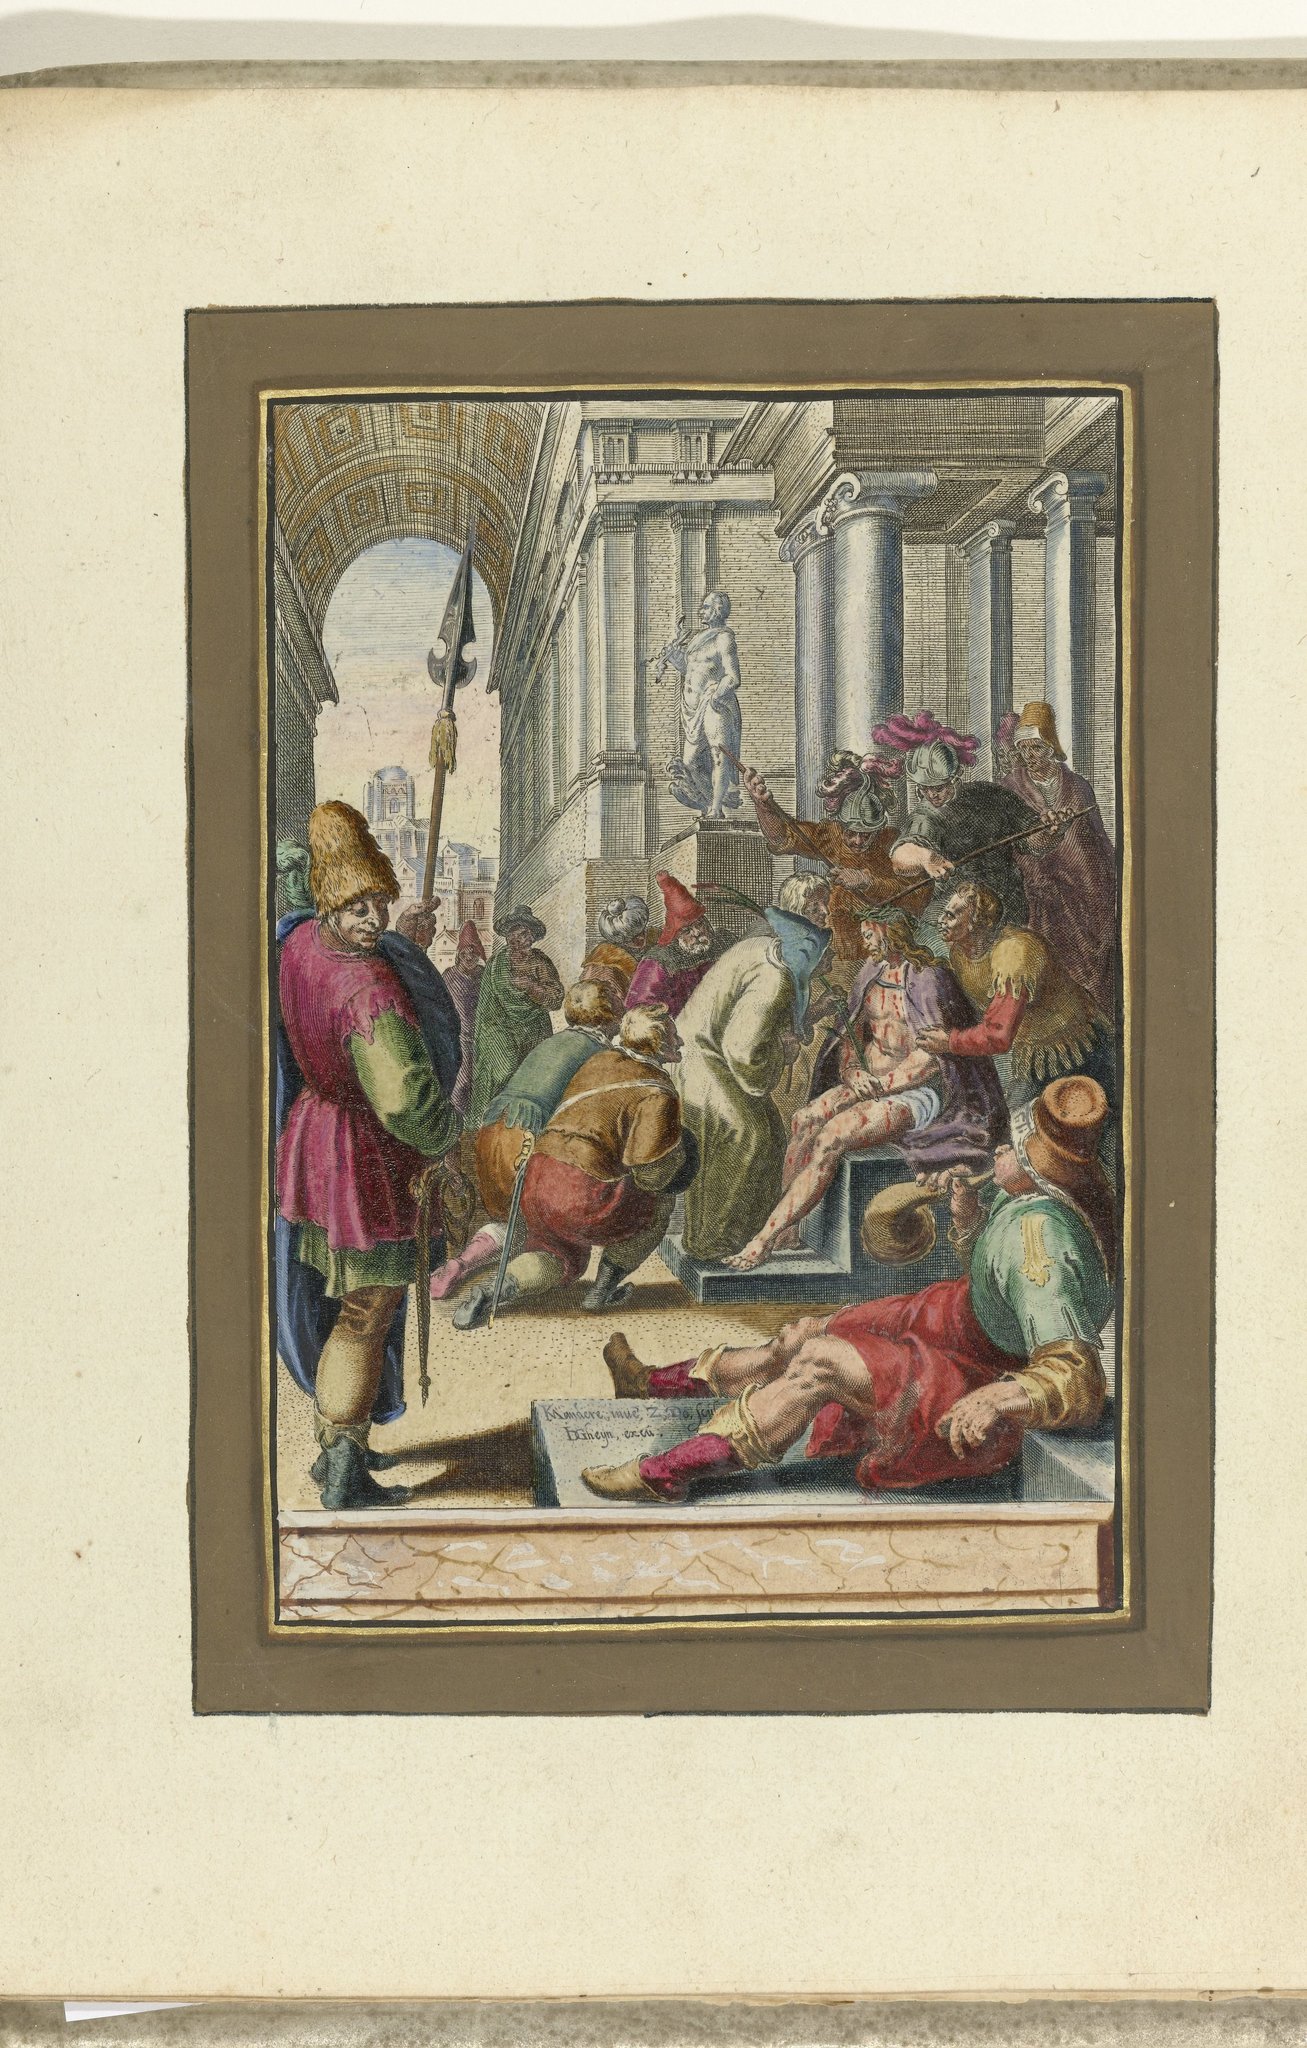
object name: album leaf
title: Doornenkroning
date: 1596-1598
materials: paper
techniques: engraving, hand coloring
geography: leiden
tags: the crowning with thorns: soldiers with sticks place a thorny crown on christ's head and give him a reed (matthew 27:27-31; mark 15:16-20; john 19:2-3)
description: Christus, zittend op een stenen trede in een tempelachtige ruimte, wordt omringd door mannen die hem een doornenkroon opzetten, een mantel omslaan, hem aanstoten, voor hem knielen en lachen. Zevende prent in een serie voorstellingen van het Lijdensverhaal. Prent maakt deel uit van een album.